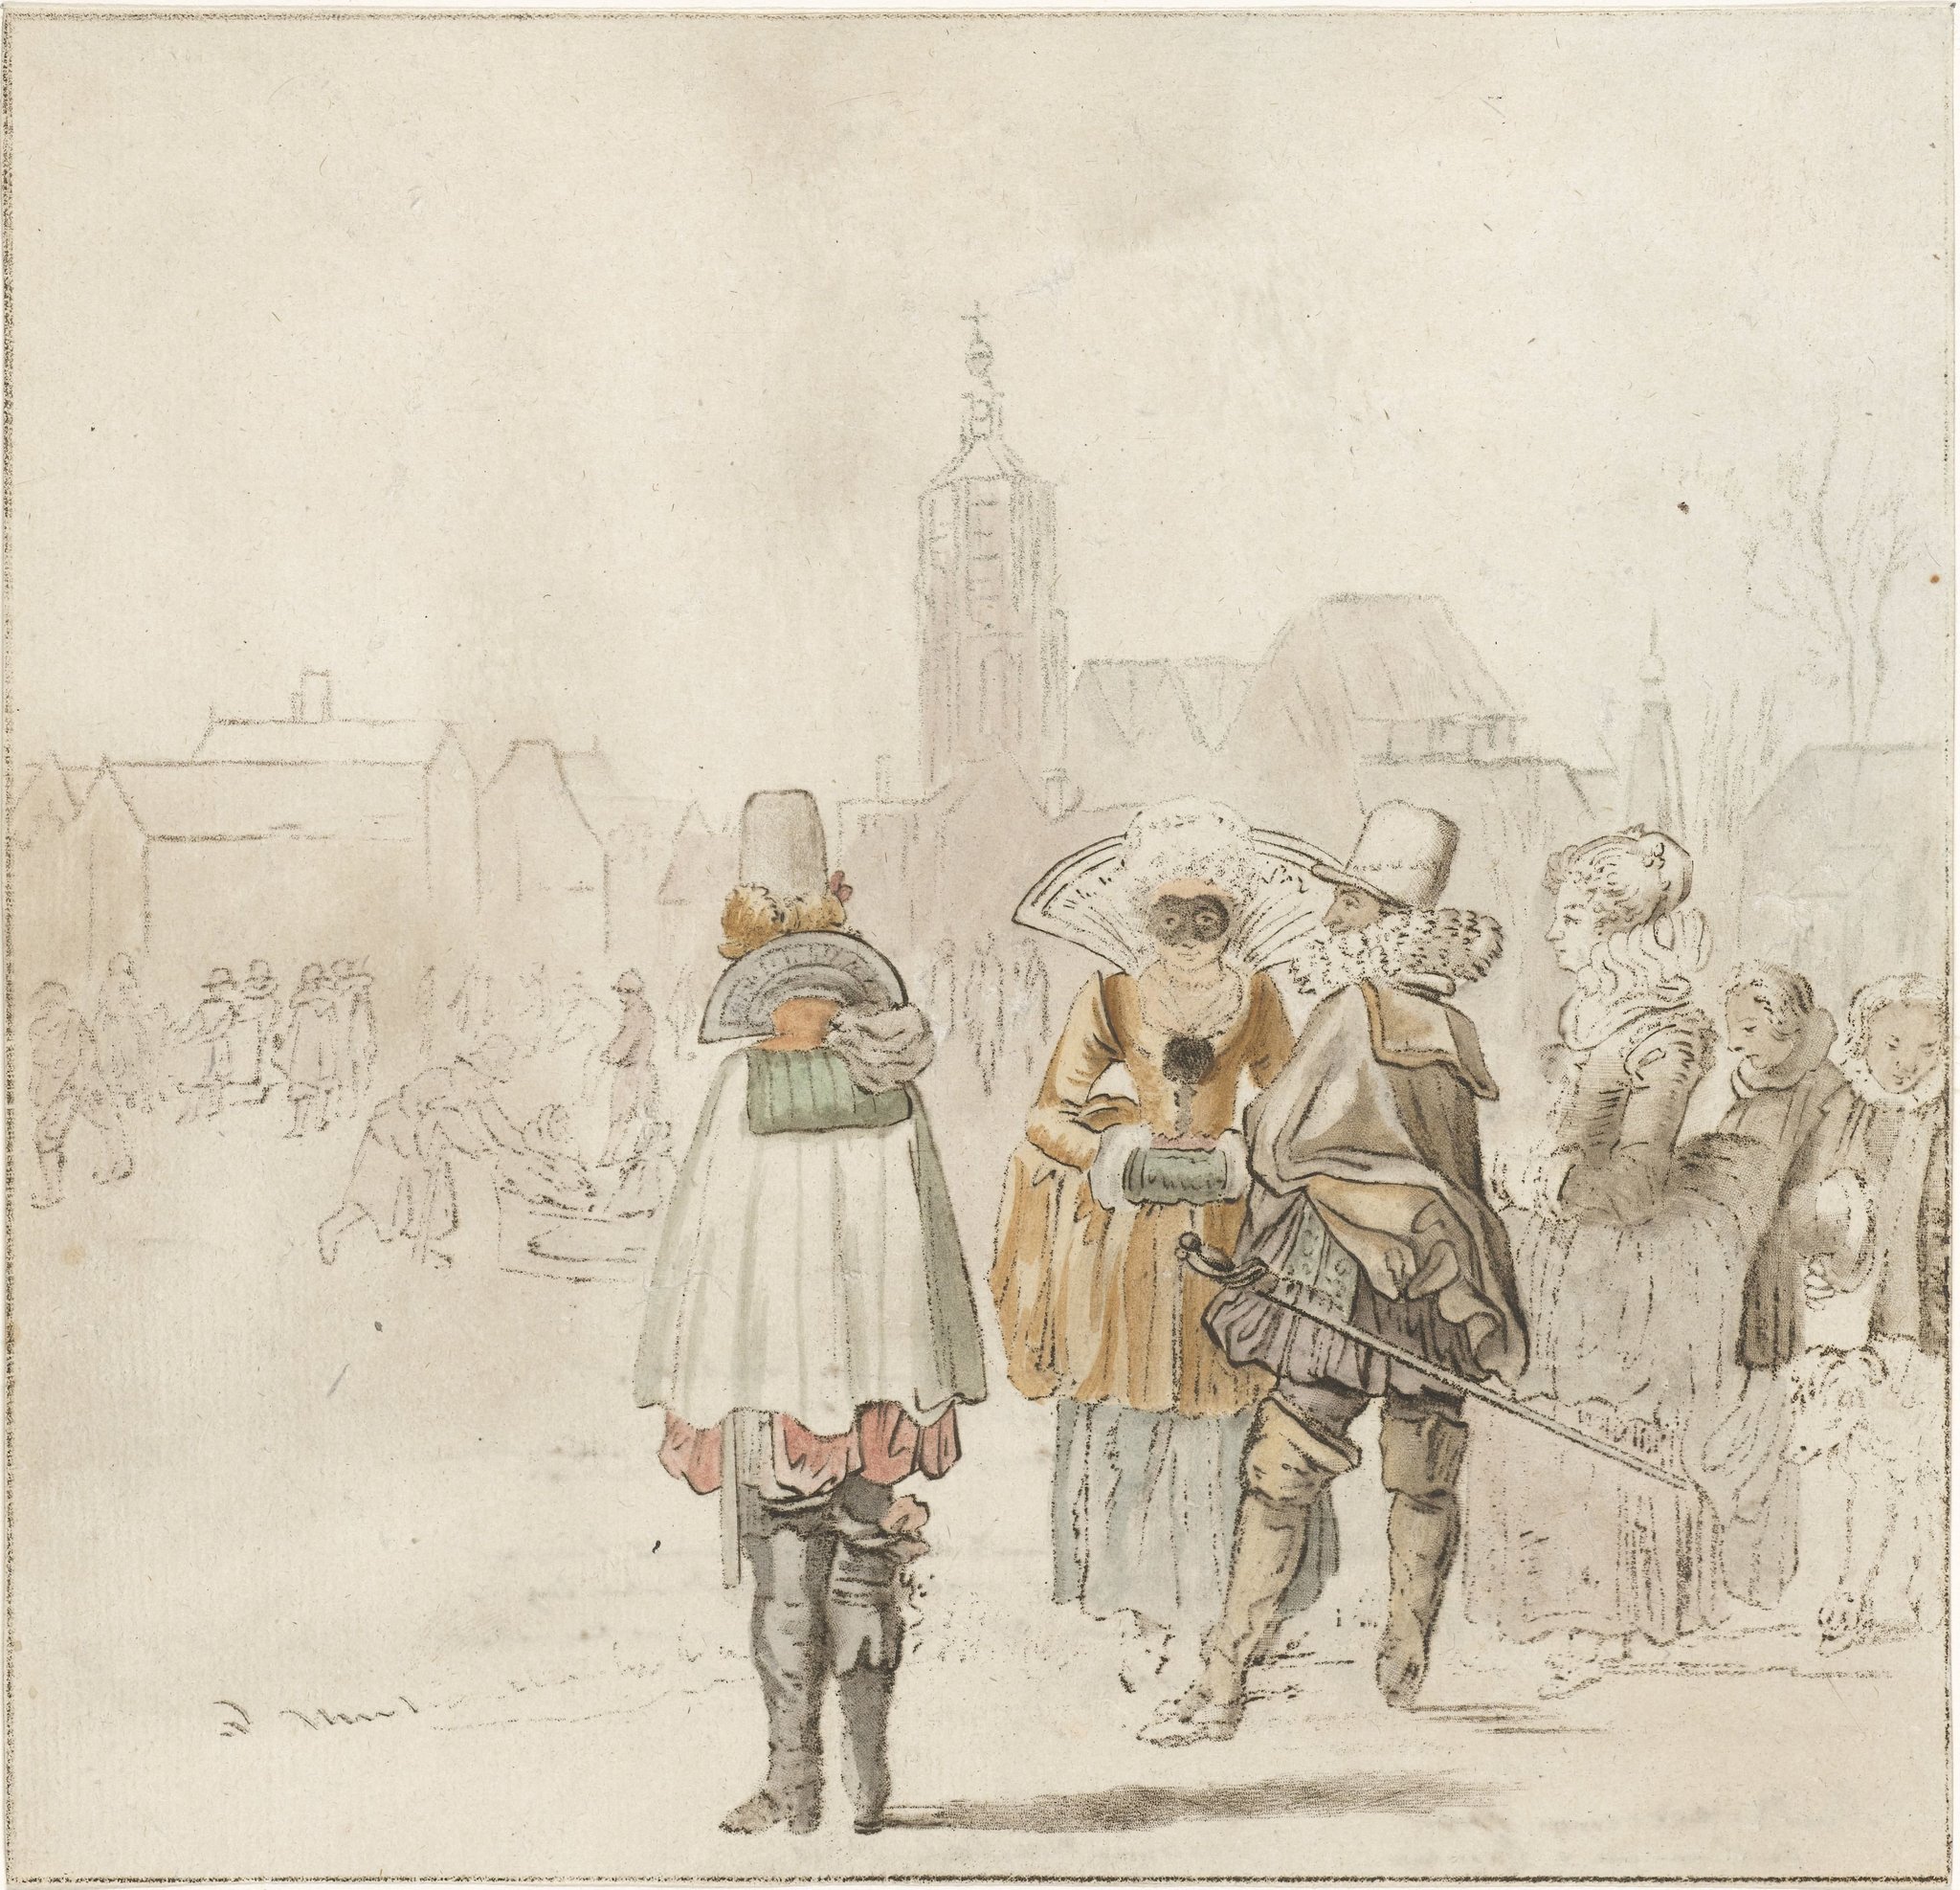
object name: print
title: De Winterkoning op het ijs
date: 1766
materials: paper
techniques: etching, hand coloring, roulette, lithography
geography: amsterdam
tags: mask, winter sports, black velvet or satin mask, 'loup', 'cachenez' (+ women's clothes), muff, clothes, costume (+ women's clothes), clothes, costume (+ men's clothes), parts of church exterior and annexes: tower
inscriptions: collector's mark: Lugt 2725, collector's mark: Lugt 240, inscription: ‘geovfreerd aan de weledele heer Jonas Witsen Burgemeester der Stad Amsterdam / in deeze druk zijn de coleuren zuyver op de plaat ingevuld, en gedrukt, dus is nog niet af, maar alleen [...] geproeft. PA / Hendr avecam del de Stomme v Campen. Ploos van Amstel F 1766’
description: Een rijk gekleed gezelschap, bestaande uit twee mannen en twee vrouwen, op het ijs.